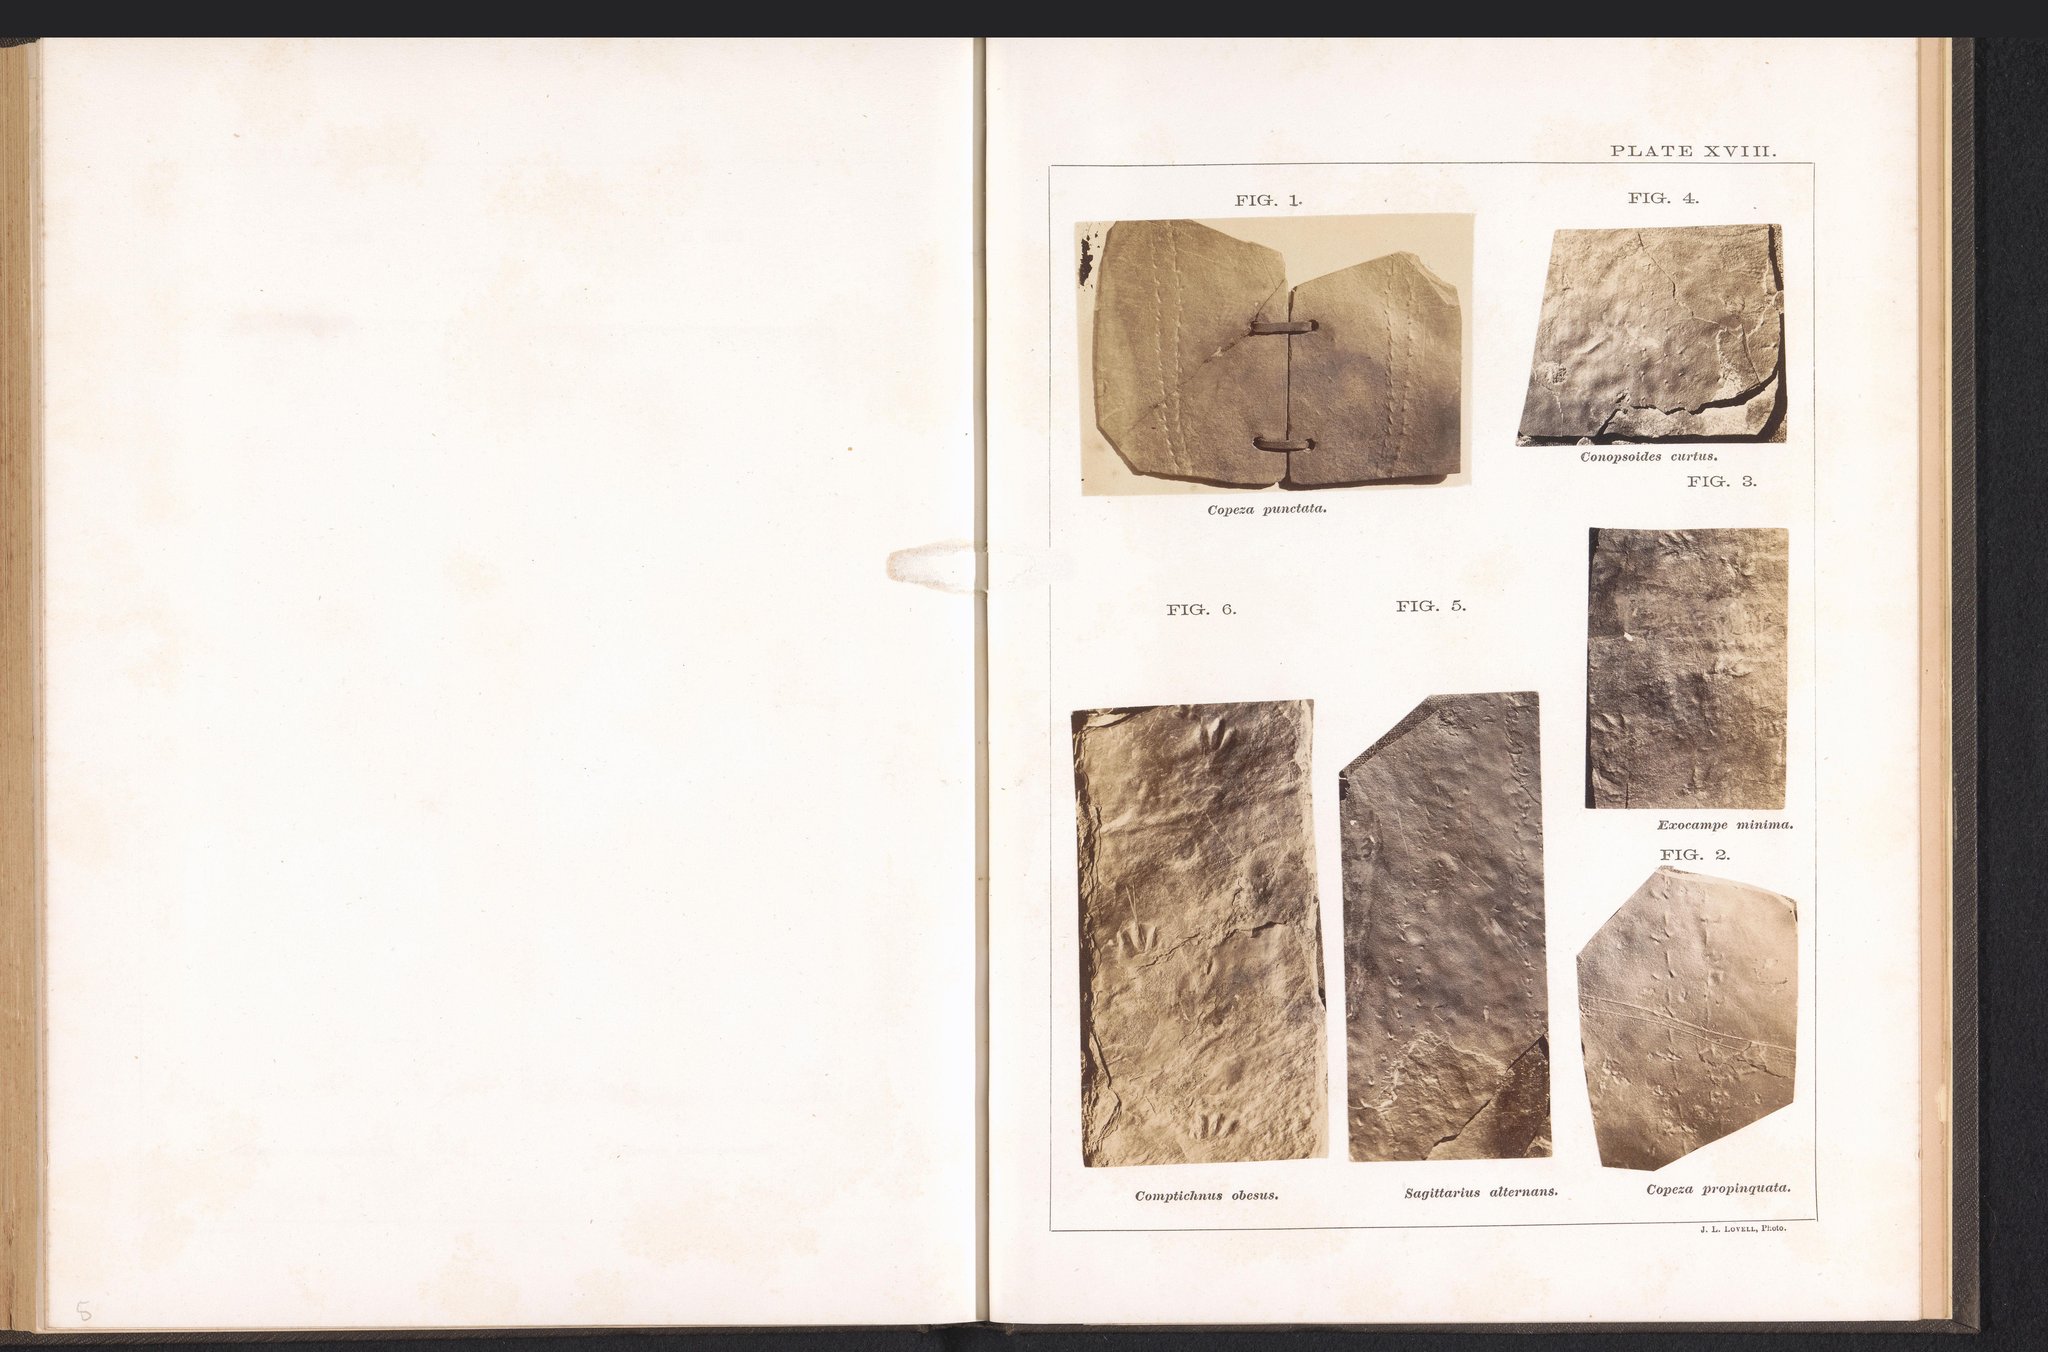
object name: page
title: Exocampe minima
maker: j.l. lovell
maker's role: fotograaf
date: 1858-1863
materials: photographic support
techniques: albumen print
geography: amherst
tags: foot-print, track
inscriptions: number: ‘Plate XVIII. Fig. 1. [...] Fig. 6.’